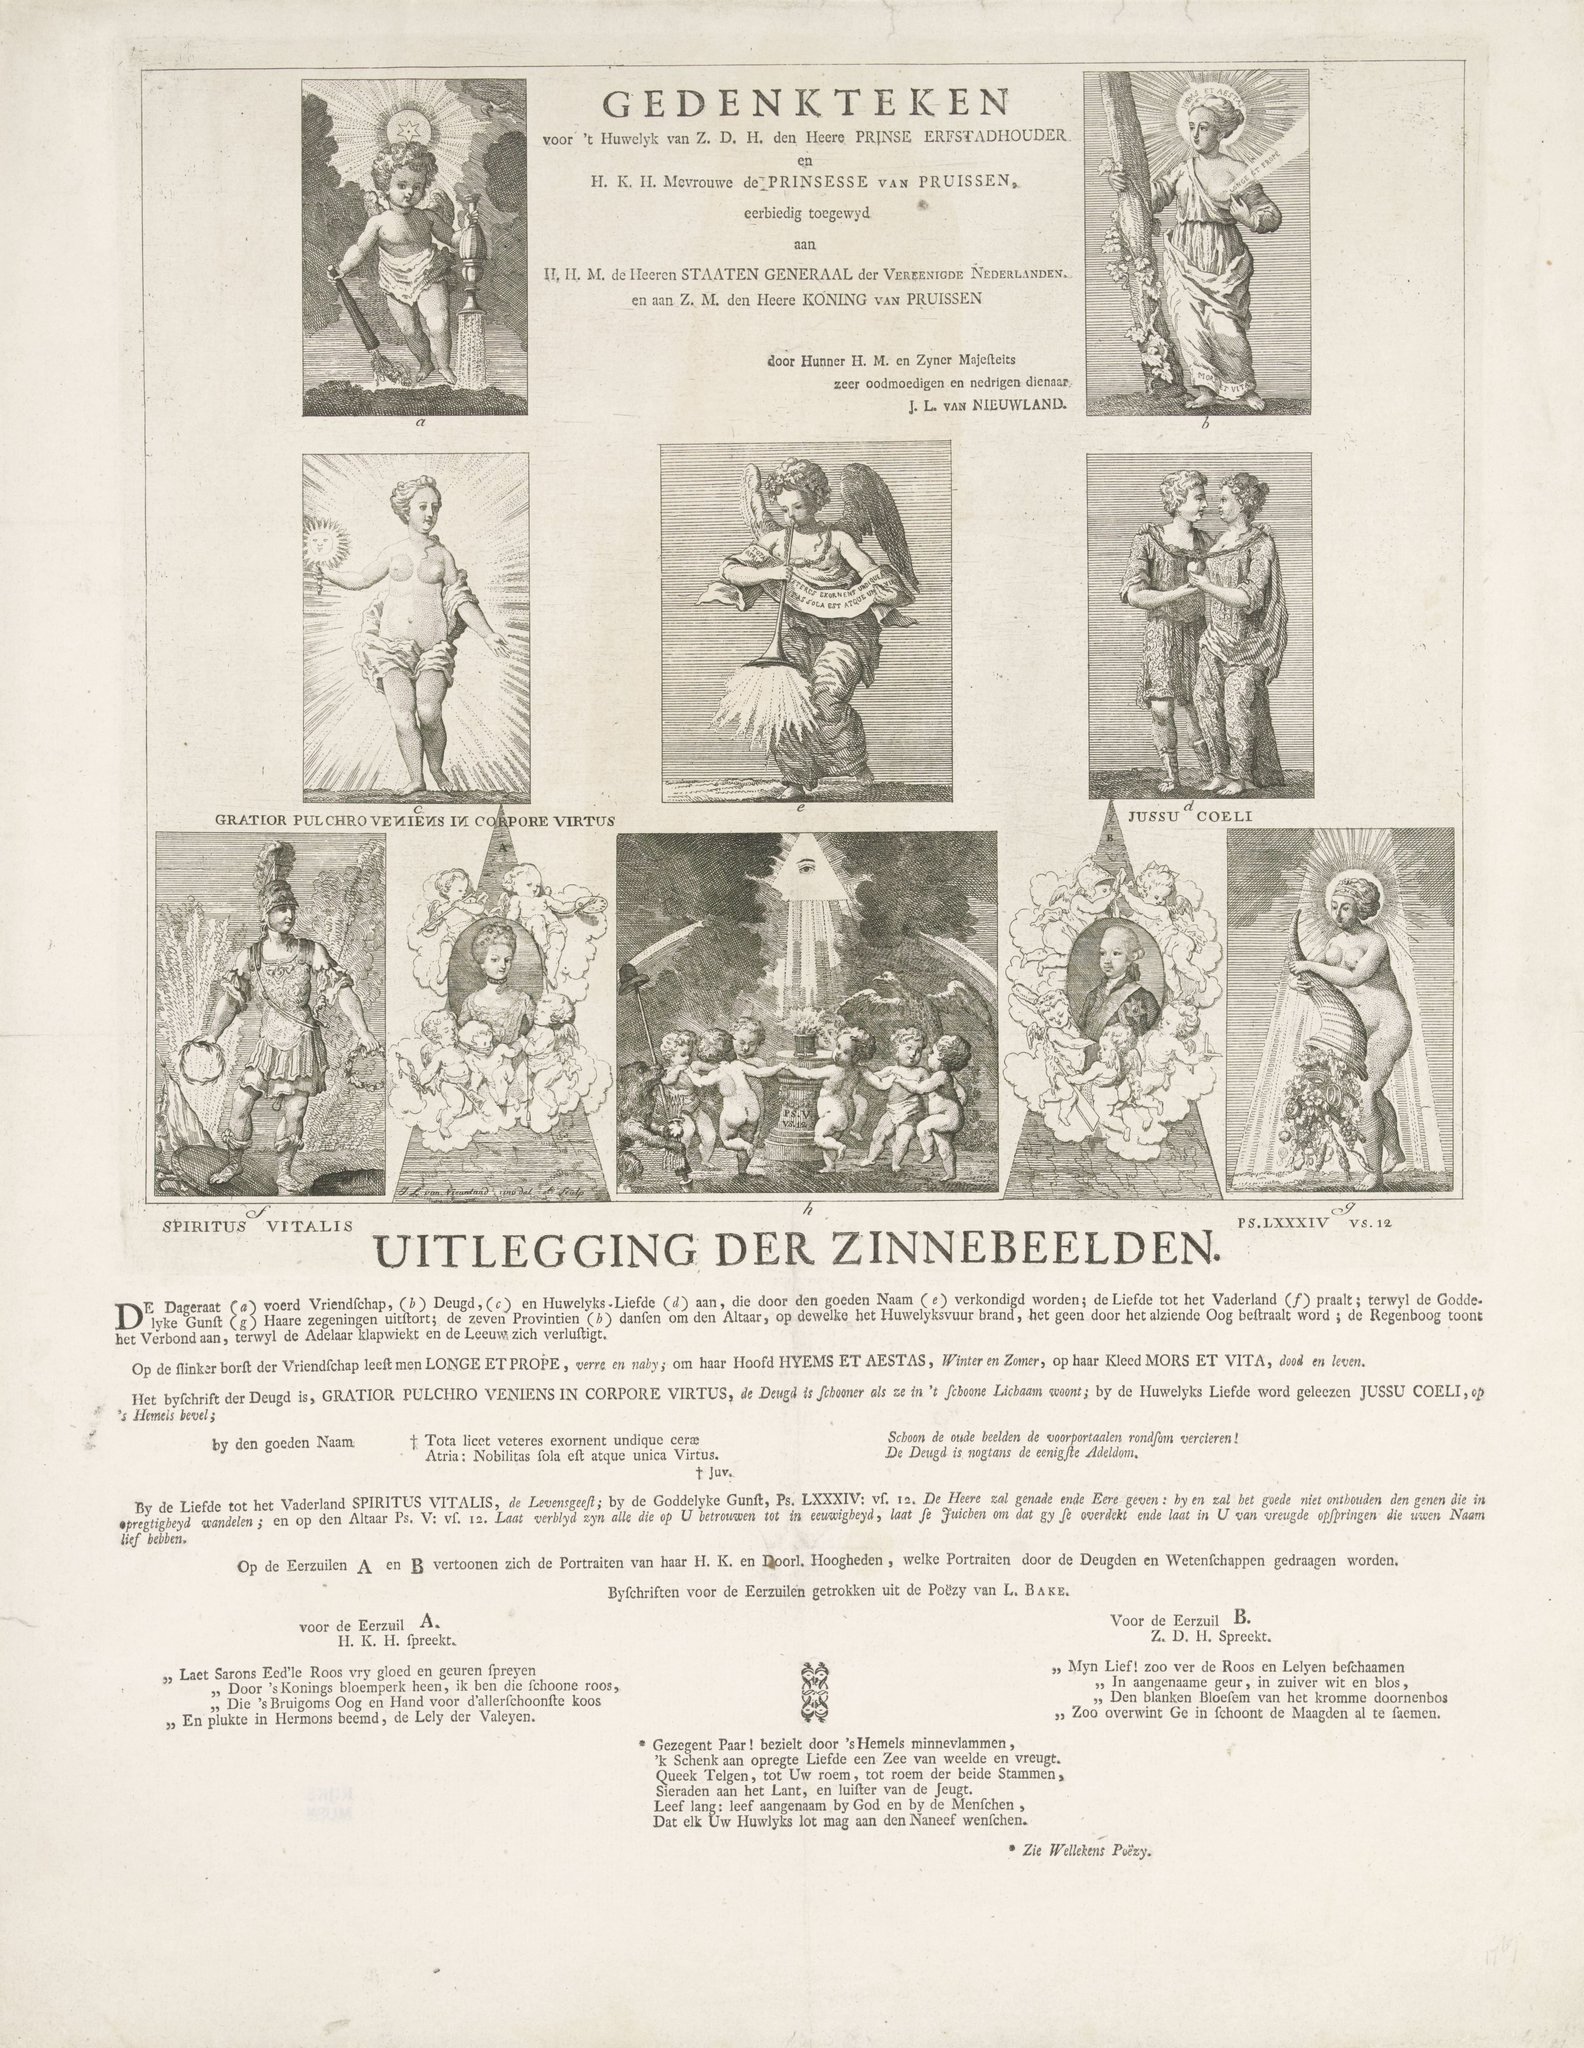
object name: print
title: Allegorie op het huwelijk van Willem V en Wilhelmina van Pruisen, 1767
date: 1767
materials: paper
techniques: engraving, etching, letterpress printing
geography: northern netherlands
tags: the hague, william v (prince of orange), berlin, draughtsman, wilhelmina of prussia (princess of orange), (civil) marriage ceremonies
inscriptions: collector's mark: Lugt 2760, collector's mark: Lugt 2228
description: Allegorie op het huwelijk van stadhouder Willem V en prinses Wilhelmina van Pruisen op 4 oktober 1767. Blad met tien allegorische voorstellingen of emblemen op het huwelijk, aangeduid met de letters a-h. Op het blad onder de prent een uitleg van de emblemen en enkele verzen in het Nederlands.